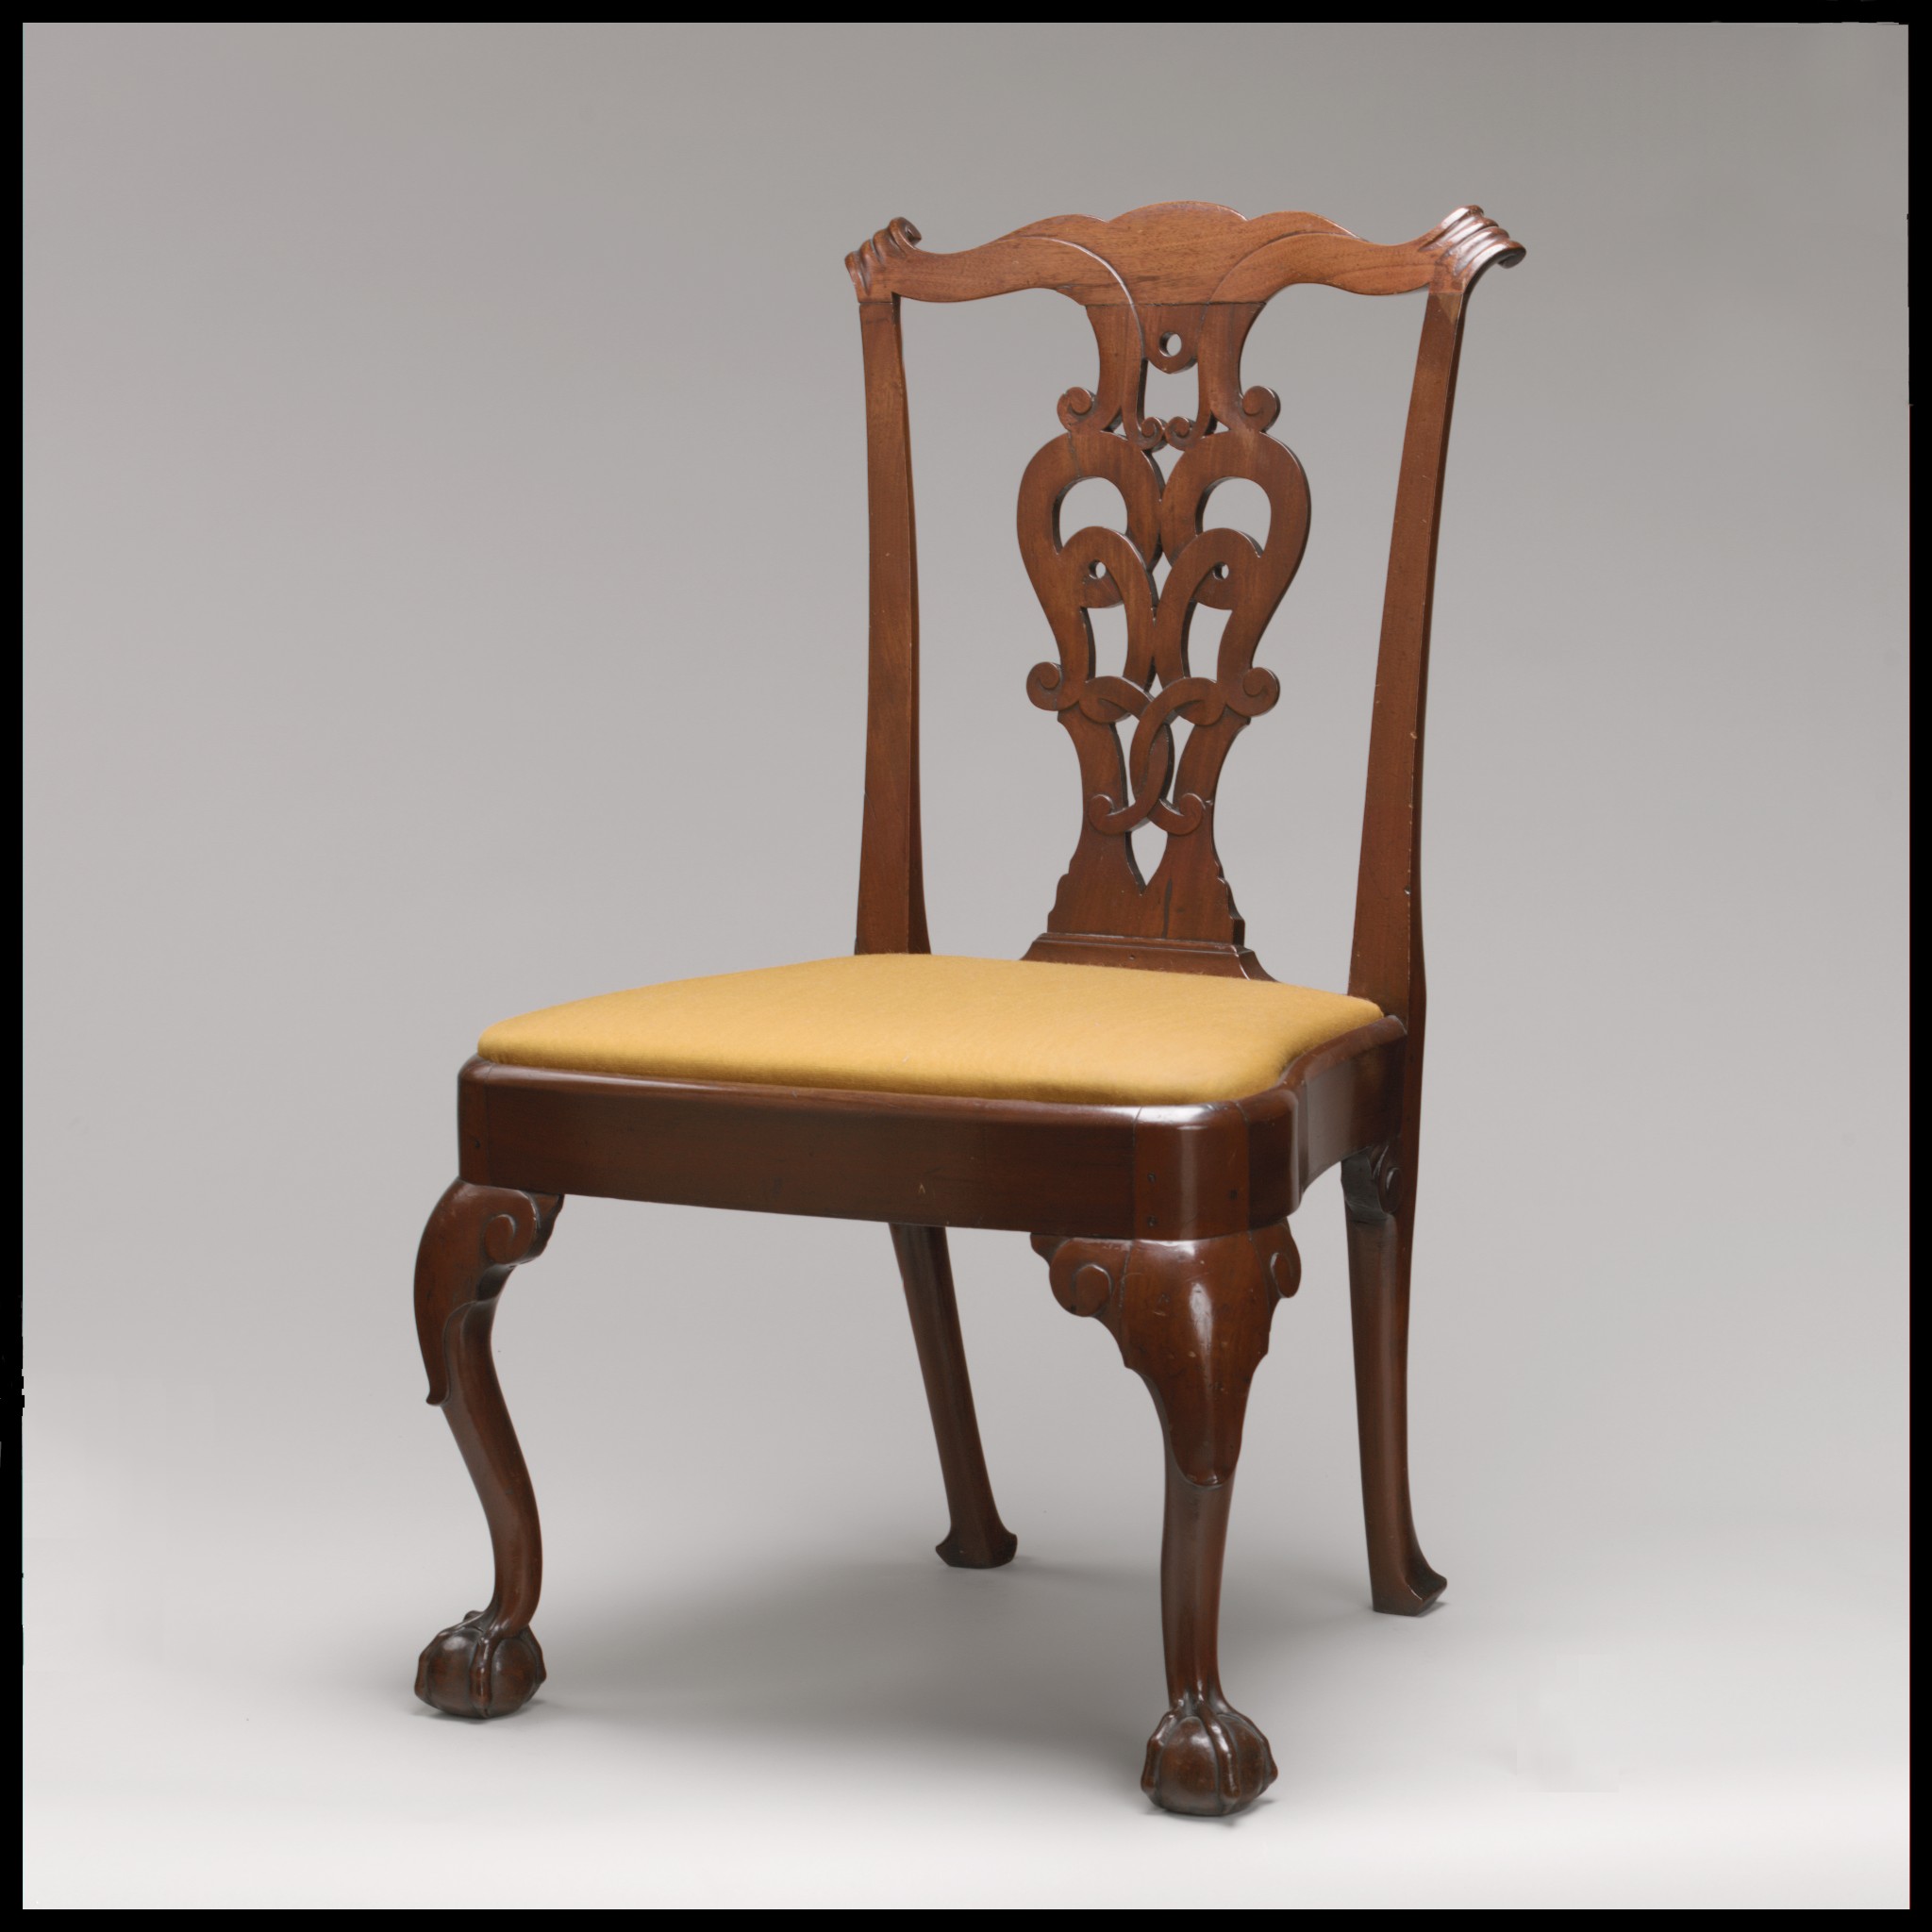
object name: side chair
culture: american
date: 1760-1790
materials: wood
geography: united states